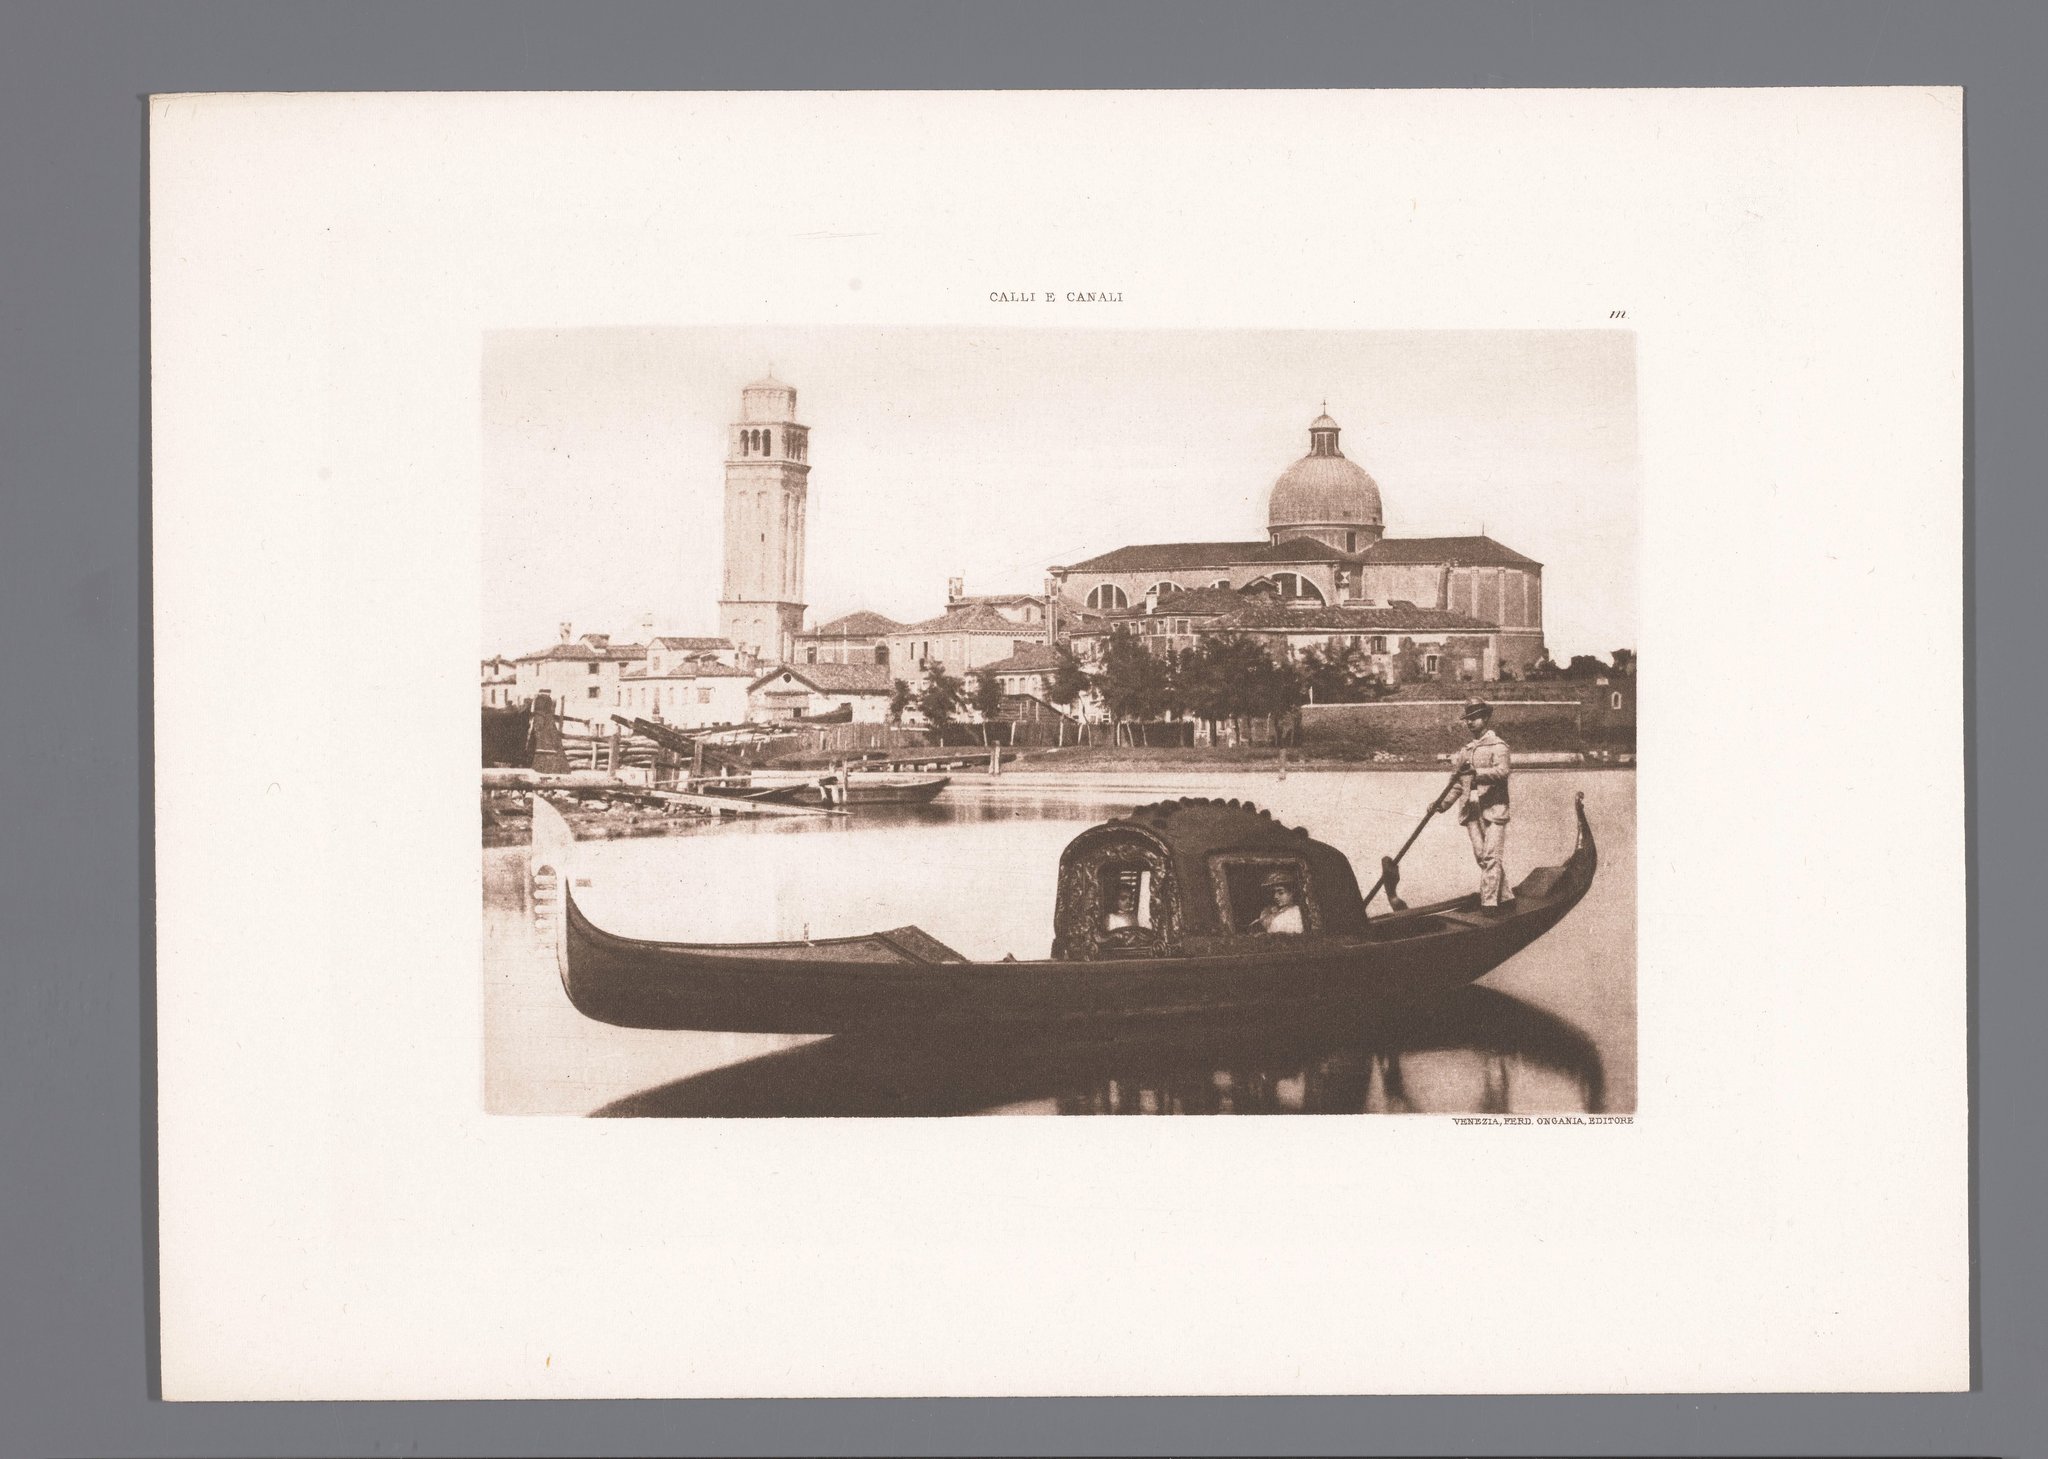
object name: page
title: Gondel met passagiers op een kanaal in Venetië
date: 1888-1898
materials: paper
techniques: photoaquatint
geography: venice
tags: canals, waters (in city), gondola, venice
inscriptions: inscription: ‘m’